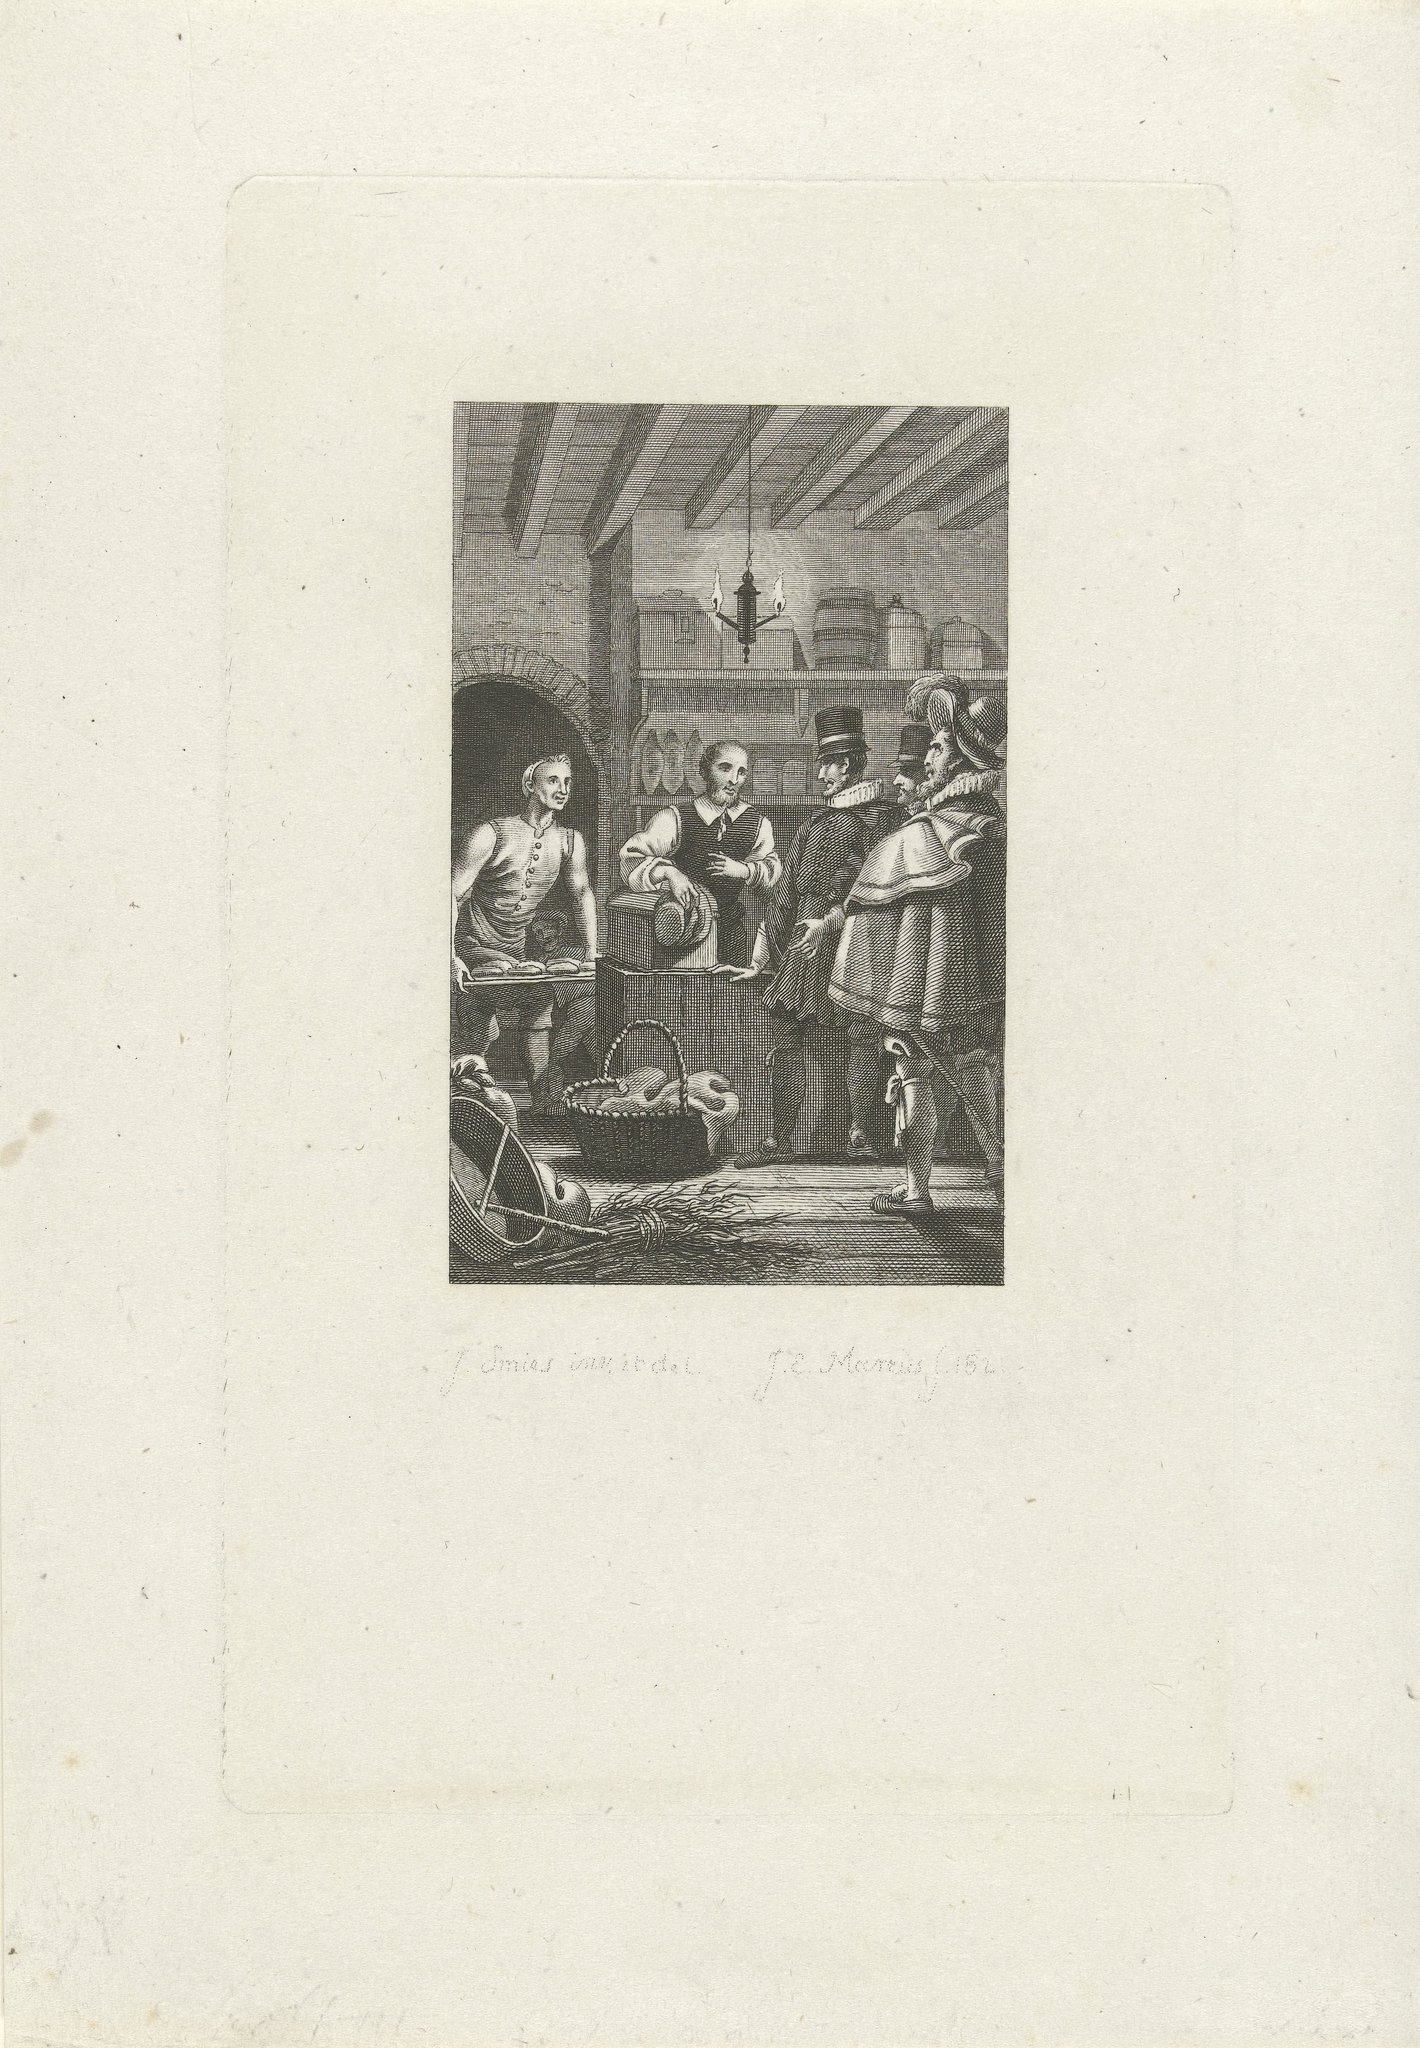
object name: print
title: Maarten Neijen te Antwerpen, 1574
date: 1821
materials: paper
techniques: etching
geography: netherlands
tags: antwerp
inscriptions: date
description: Maarten Neijen te Antwerpen, 1574. Het complot van Maarten Neijen, klerk of griffier van de Antwerpse Rekenkamer om de stad in handen van Oranje te brengen. Enkele mannen komen in de winkel waar Neijen en anderen verstopt waren voor een huiszoeking.